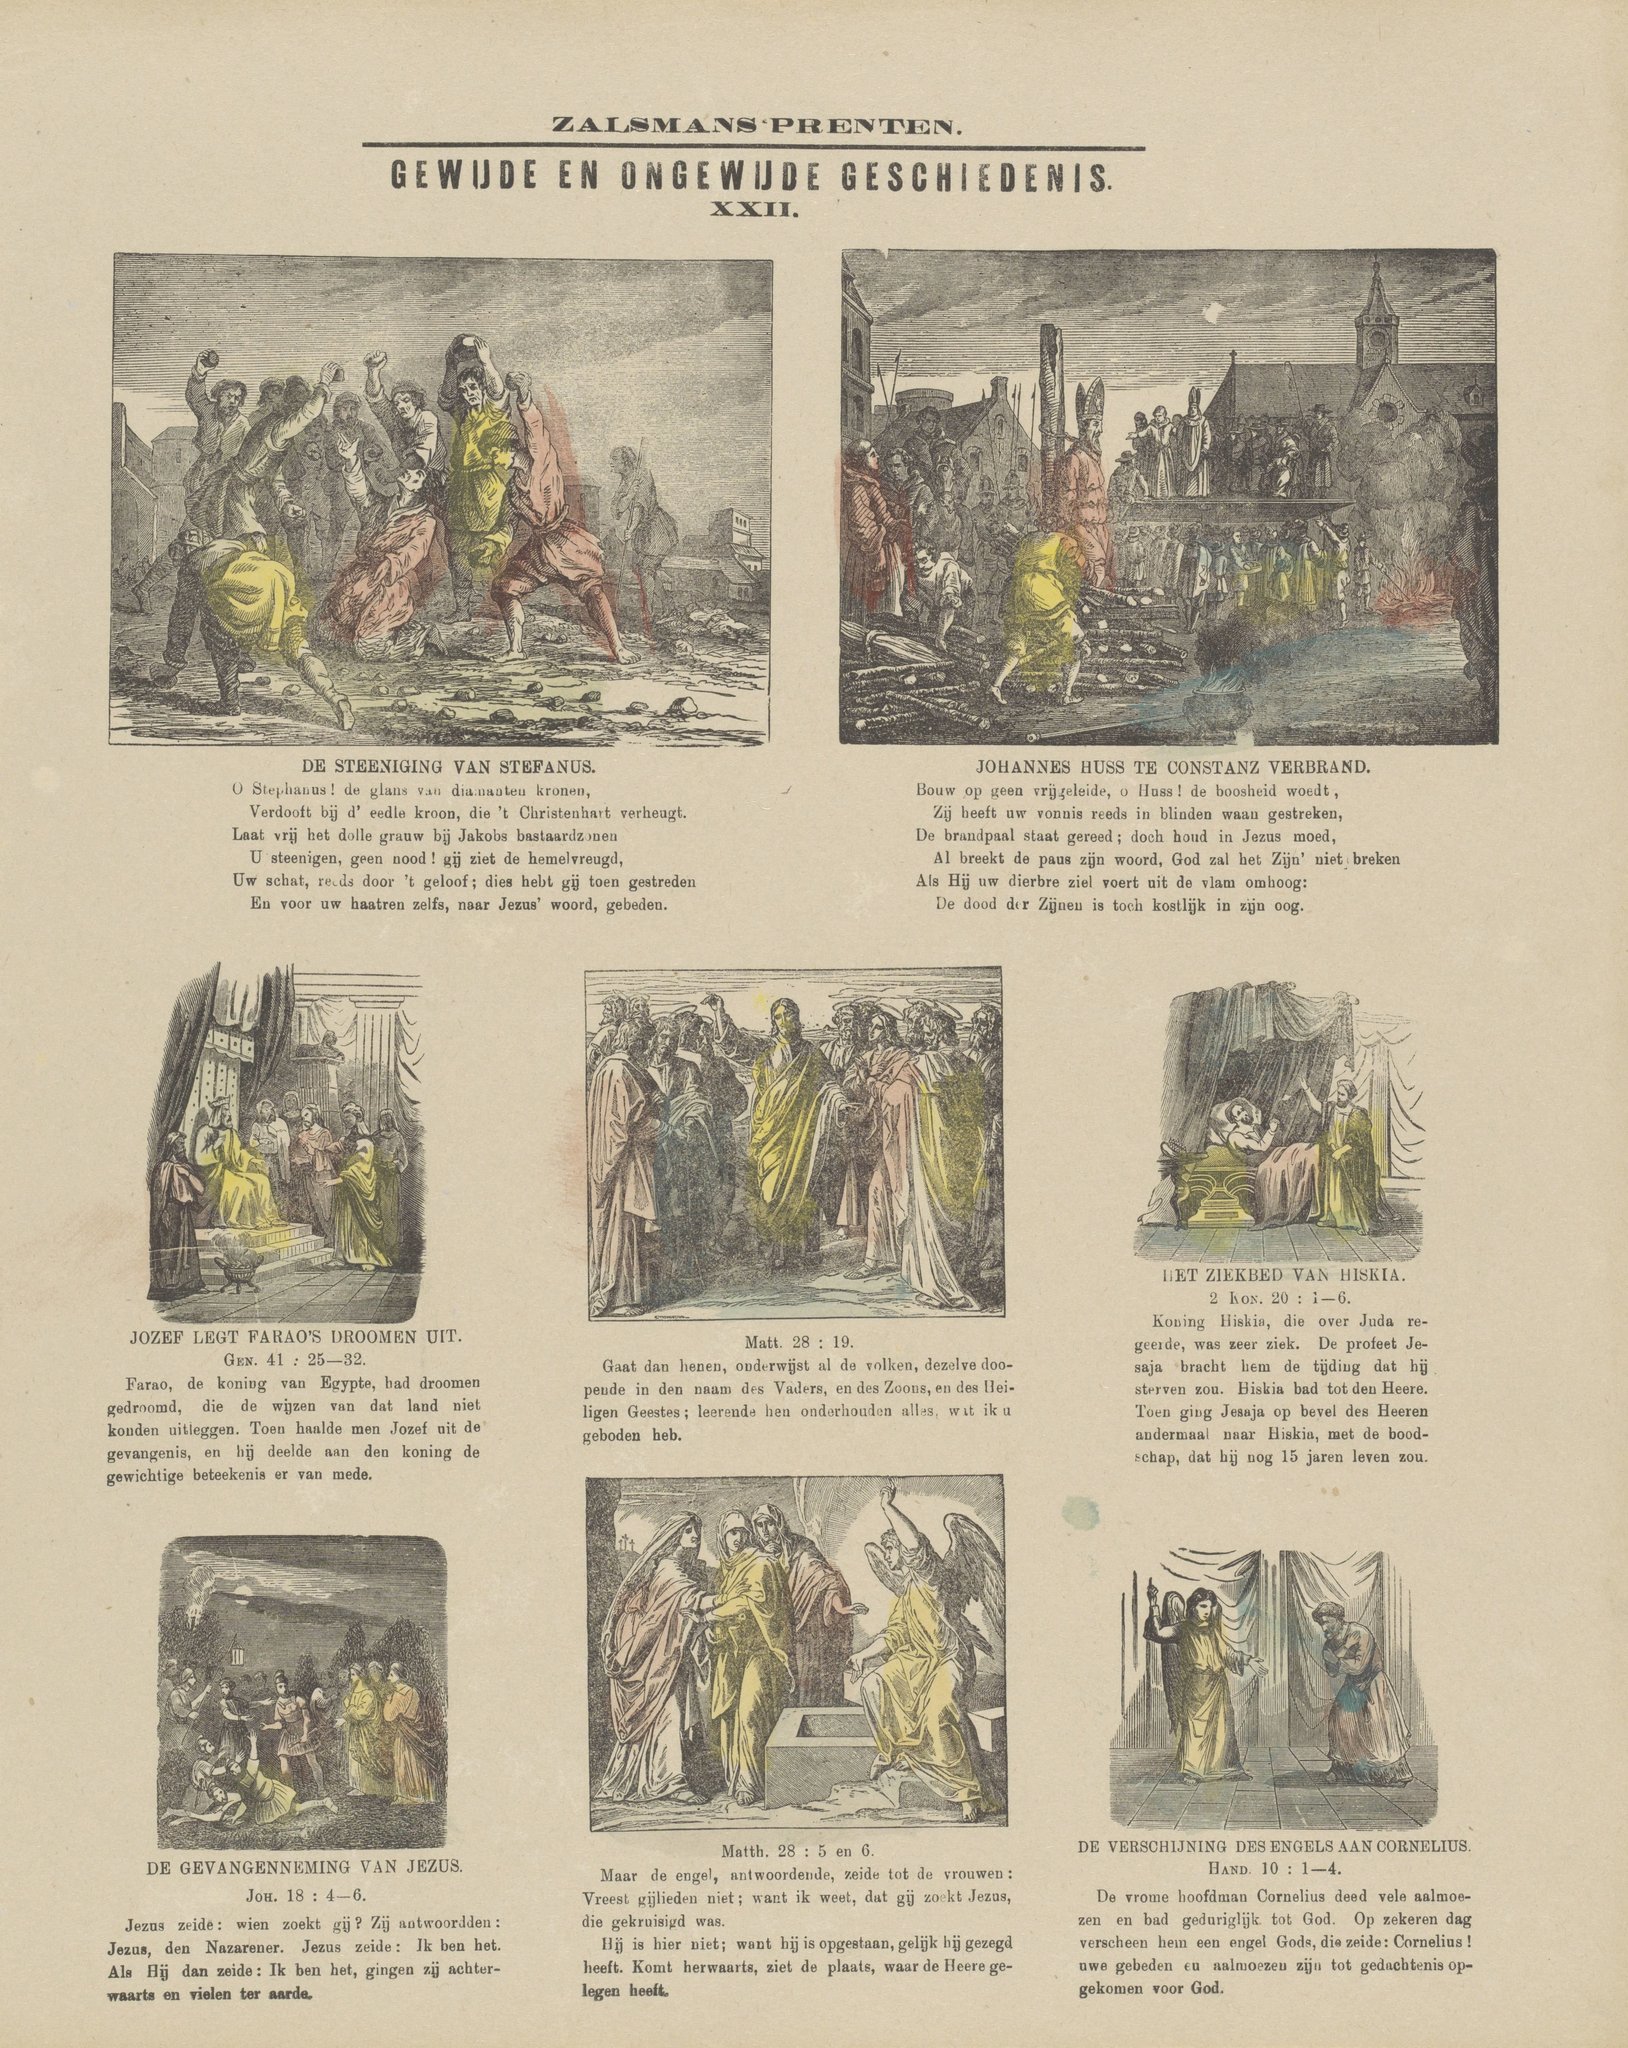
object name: print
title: Gewijde en ongewijde geschiedenis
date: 1869-1882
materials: paper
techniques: colour, letterpress printing, engraving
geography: europe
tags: new testament, old testament, series of scenes from the life of christ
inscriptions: collector's mark: Lugt 2760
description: Blad met 8 voorstellingen van verhalen uit het Oude en het Nieuwe Testament. Onder elke voorstelling een onderschrift en een verwijzing naar de bijbehorende Bijbeltekst. Genummerd midden boven: XXII.